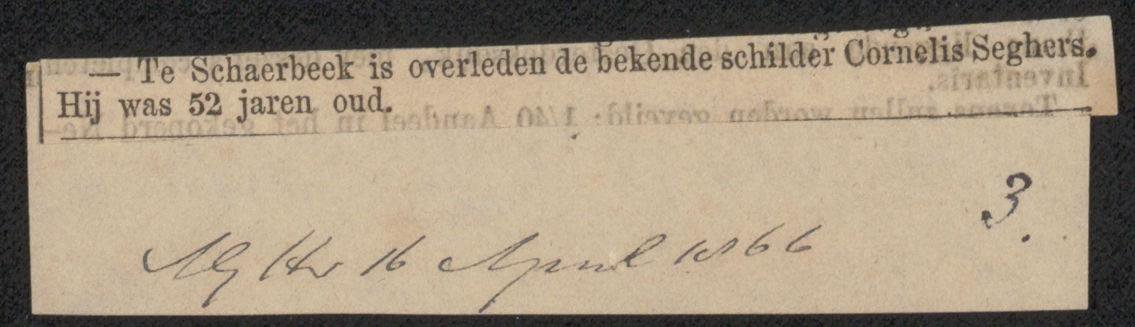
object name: newspaper clipping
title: Krantenknipsel betreffende Corneille Seghers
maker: Anonymous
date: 1866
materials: paper, ink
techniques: printing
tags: antwerp, print maker, draughtsman, corneille seghers